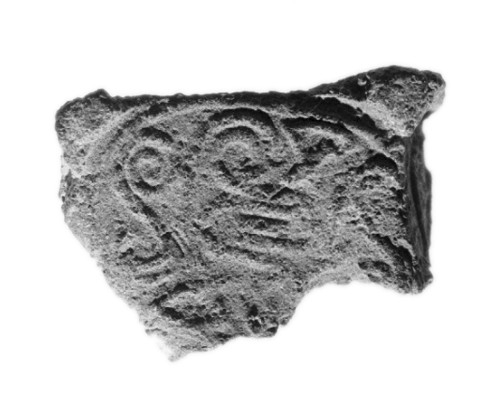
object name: sealing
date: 1981-1640 BCE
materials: clay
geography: egypt